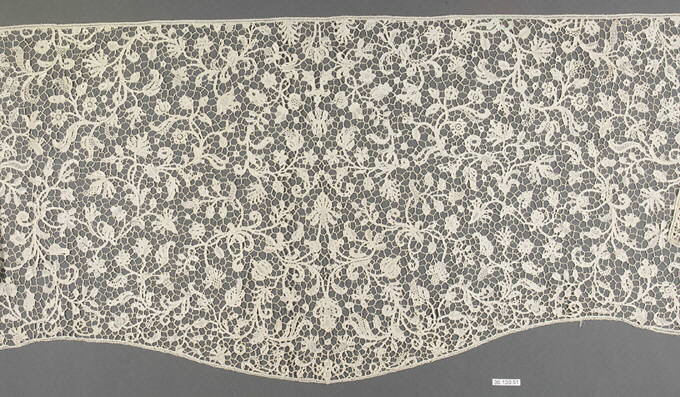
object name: panel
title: Shaped panel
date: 1601-1800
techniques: lace